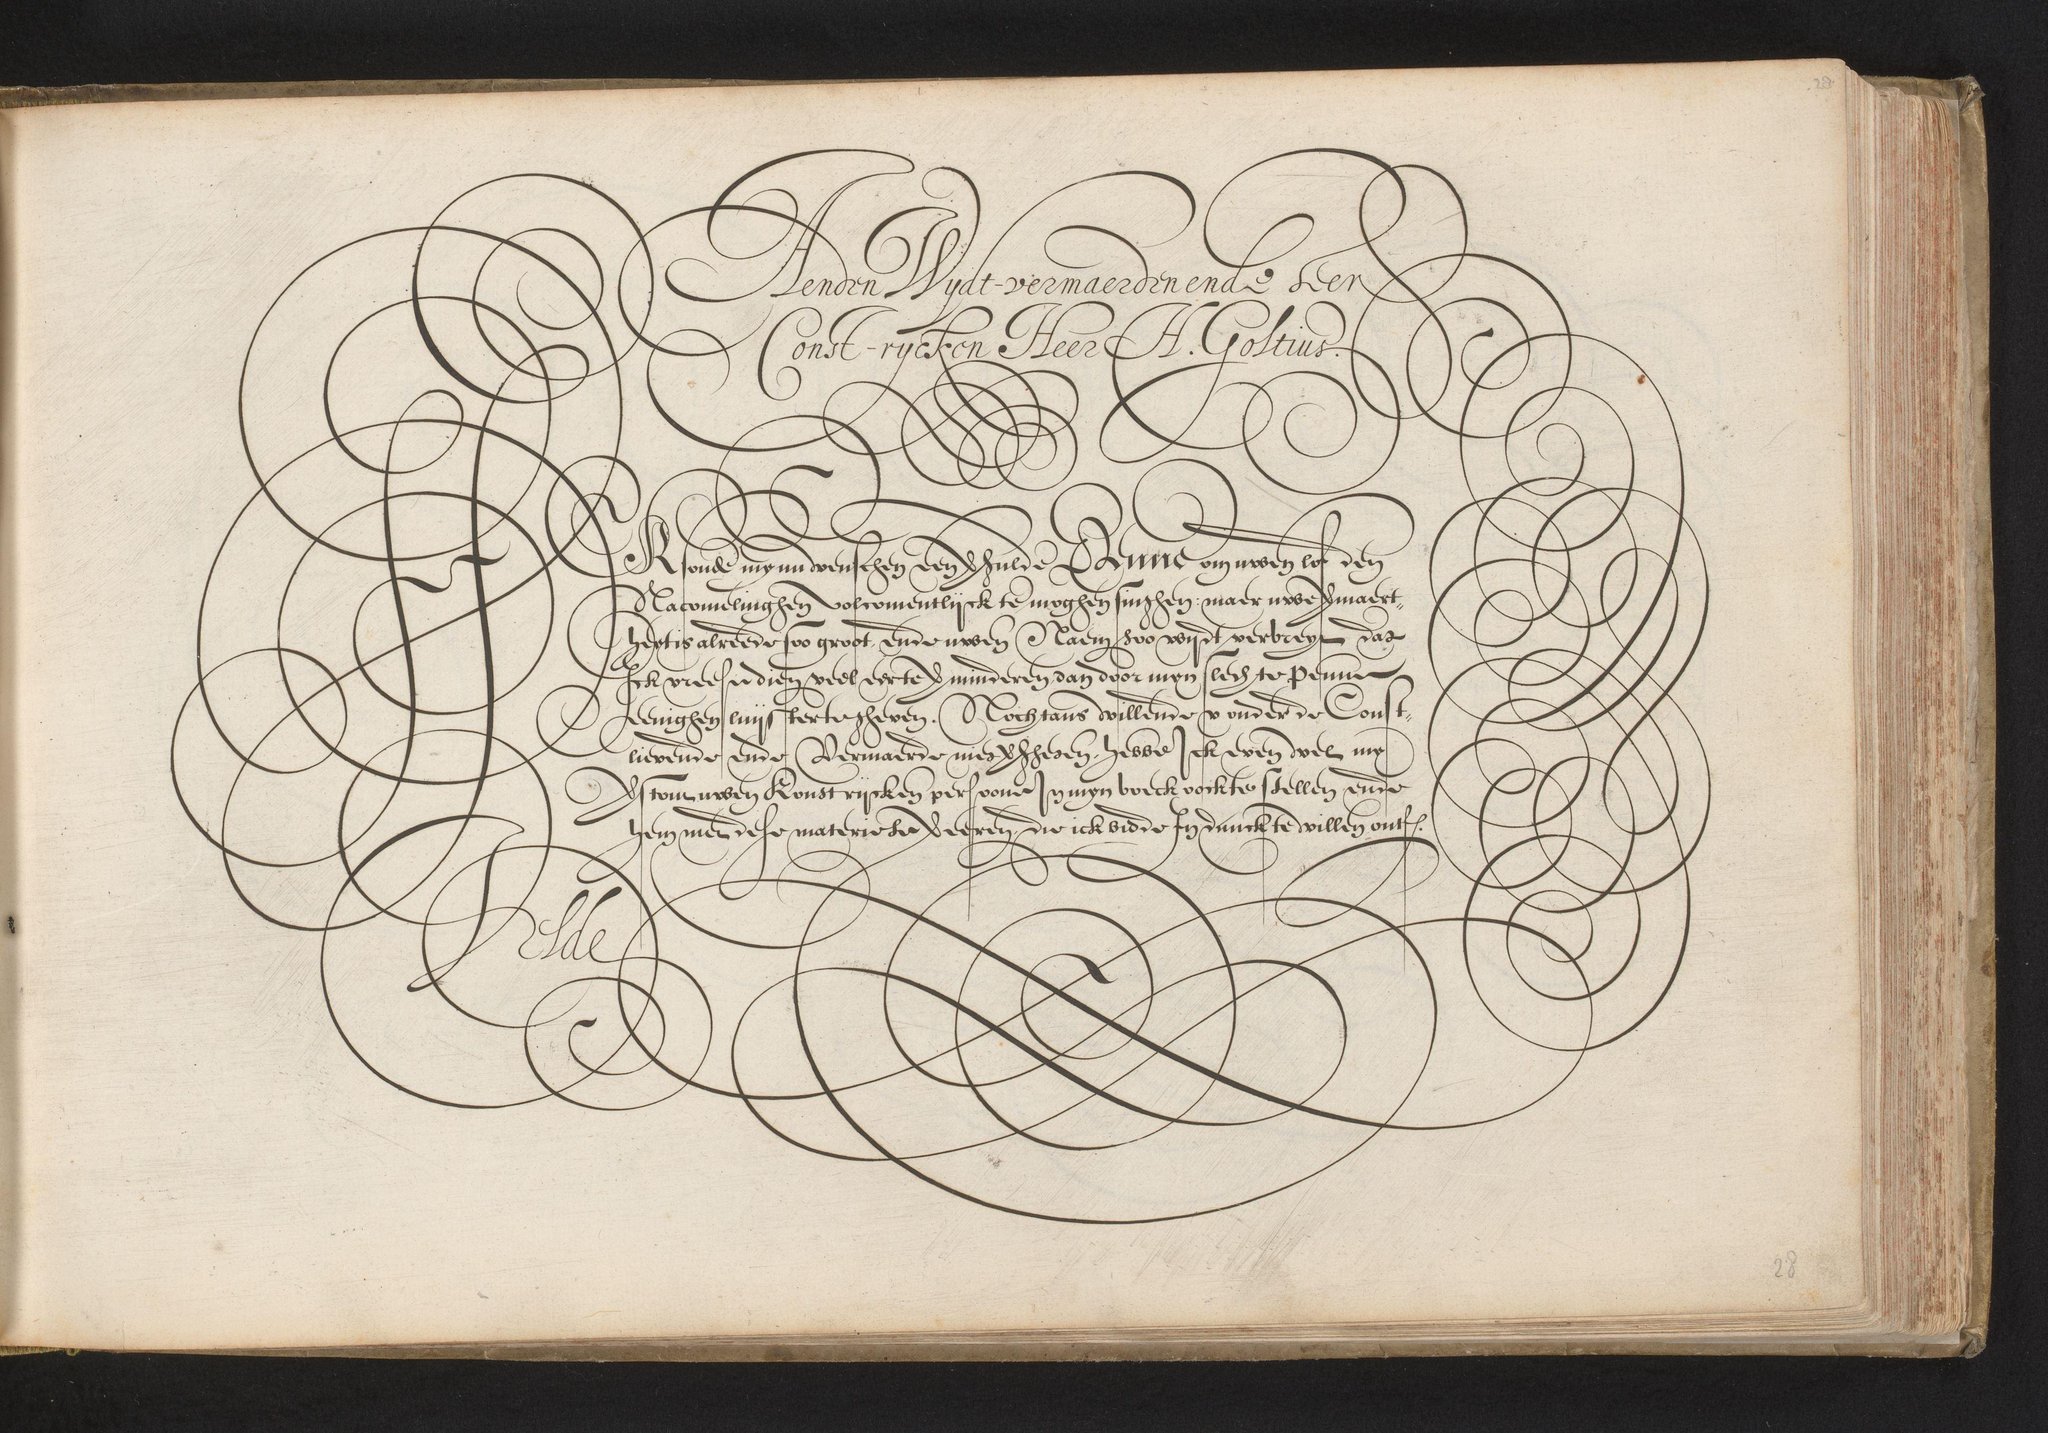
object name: album leaf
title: Spieghel der schrijfkonste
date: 1605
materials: paper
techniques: engraving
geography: rotterdam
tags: calligraphy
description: Schrijfvoorbeeld met de aanhef: Aenden wyt-vermaerden ende seer const-rycken heer H. Goltius. Daaronder in een andere letter een initiaal I en acht regels tekst in het Nederlands: Ick soude my ... De tekst is omlijst door krulwerk. De prent maakt deel uit van een album.